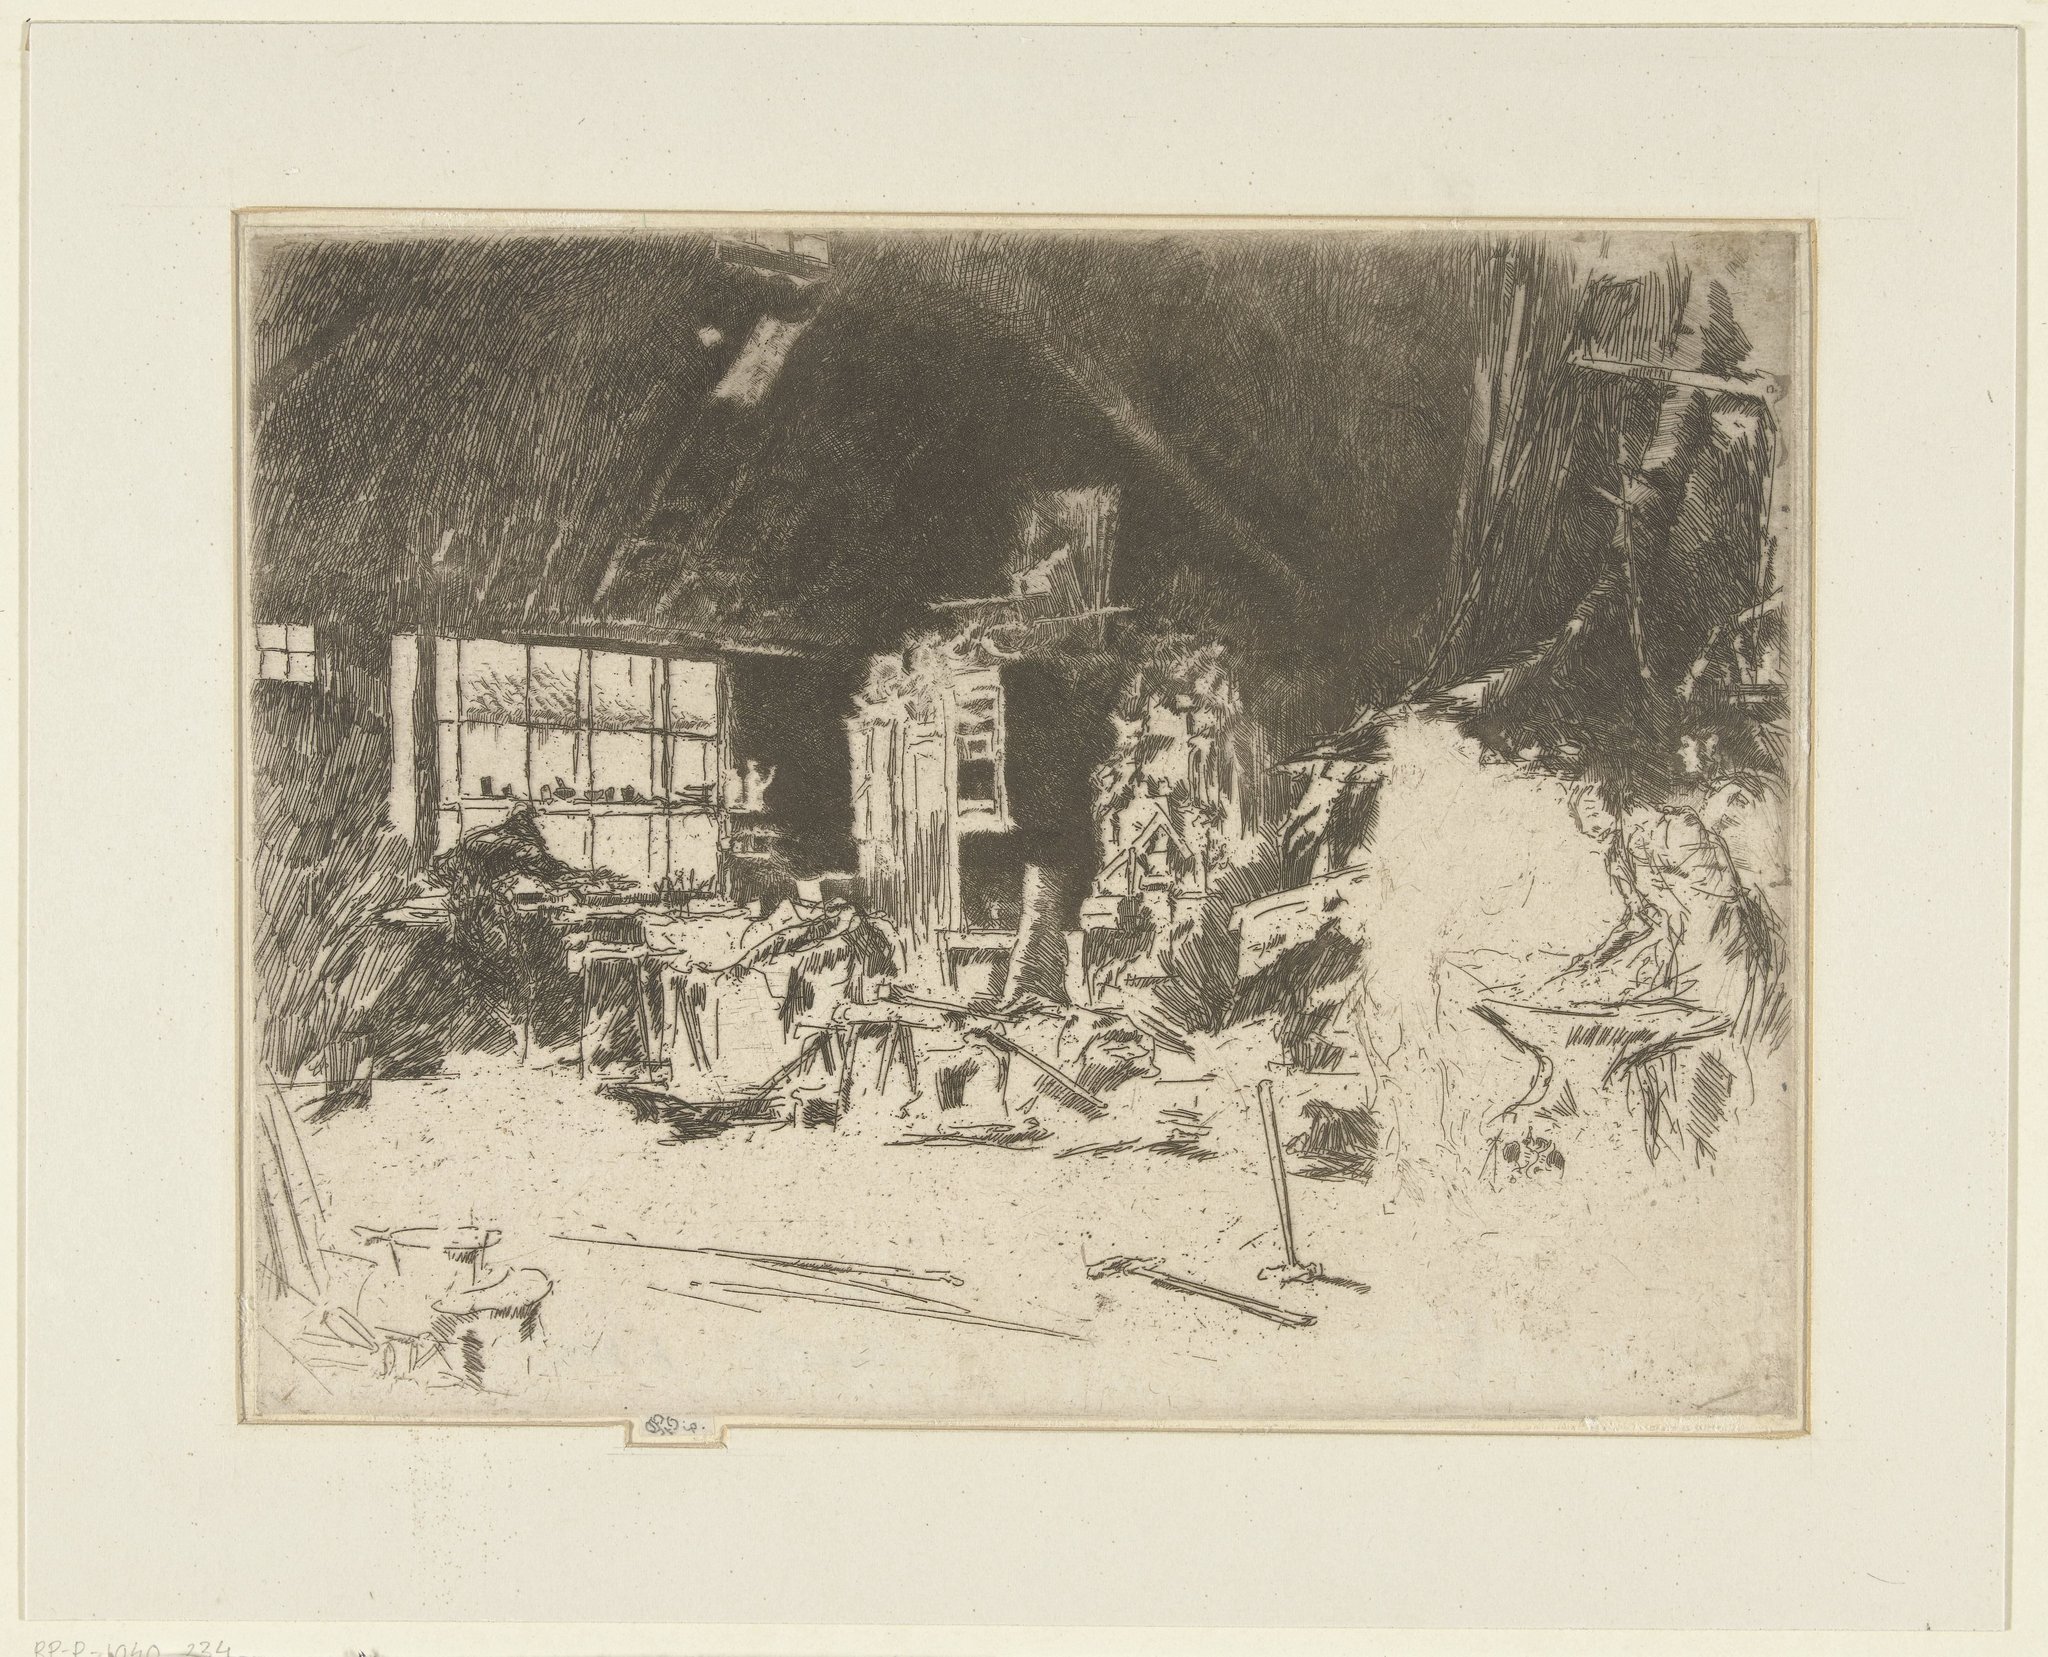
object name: print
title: The Smithy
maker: james abbott mcneill whistler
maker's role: painter, print maker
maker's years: 1834-1903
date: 1879-1883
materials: paper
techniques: drypoint, etching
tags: smith, blacksmith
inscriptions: collector's mark: Lugt 2166, collector's mark: Lugt 2760, signature: ‘JW imp’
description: Interieur van een smidse. Rechts een man aan het werk op een aambeeld.